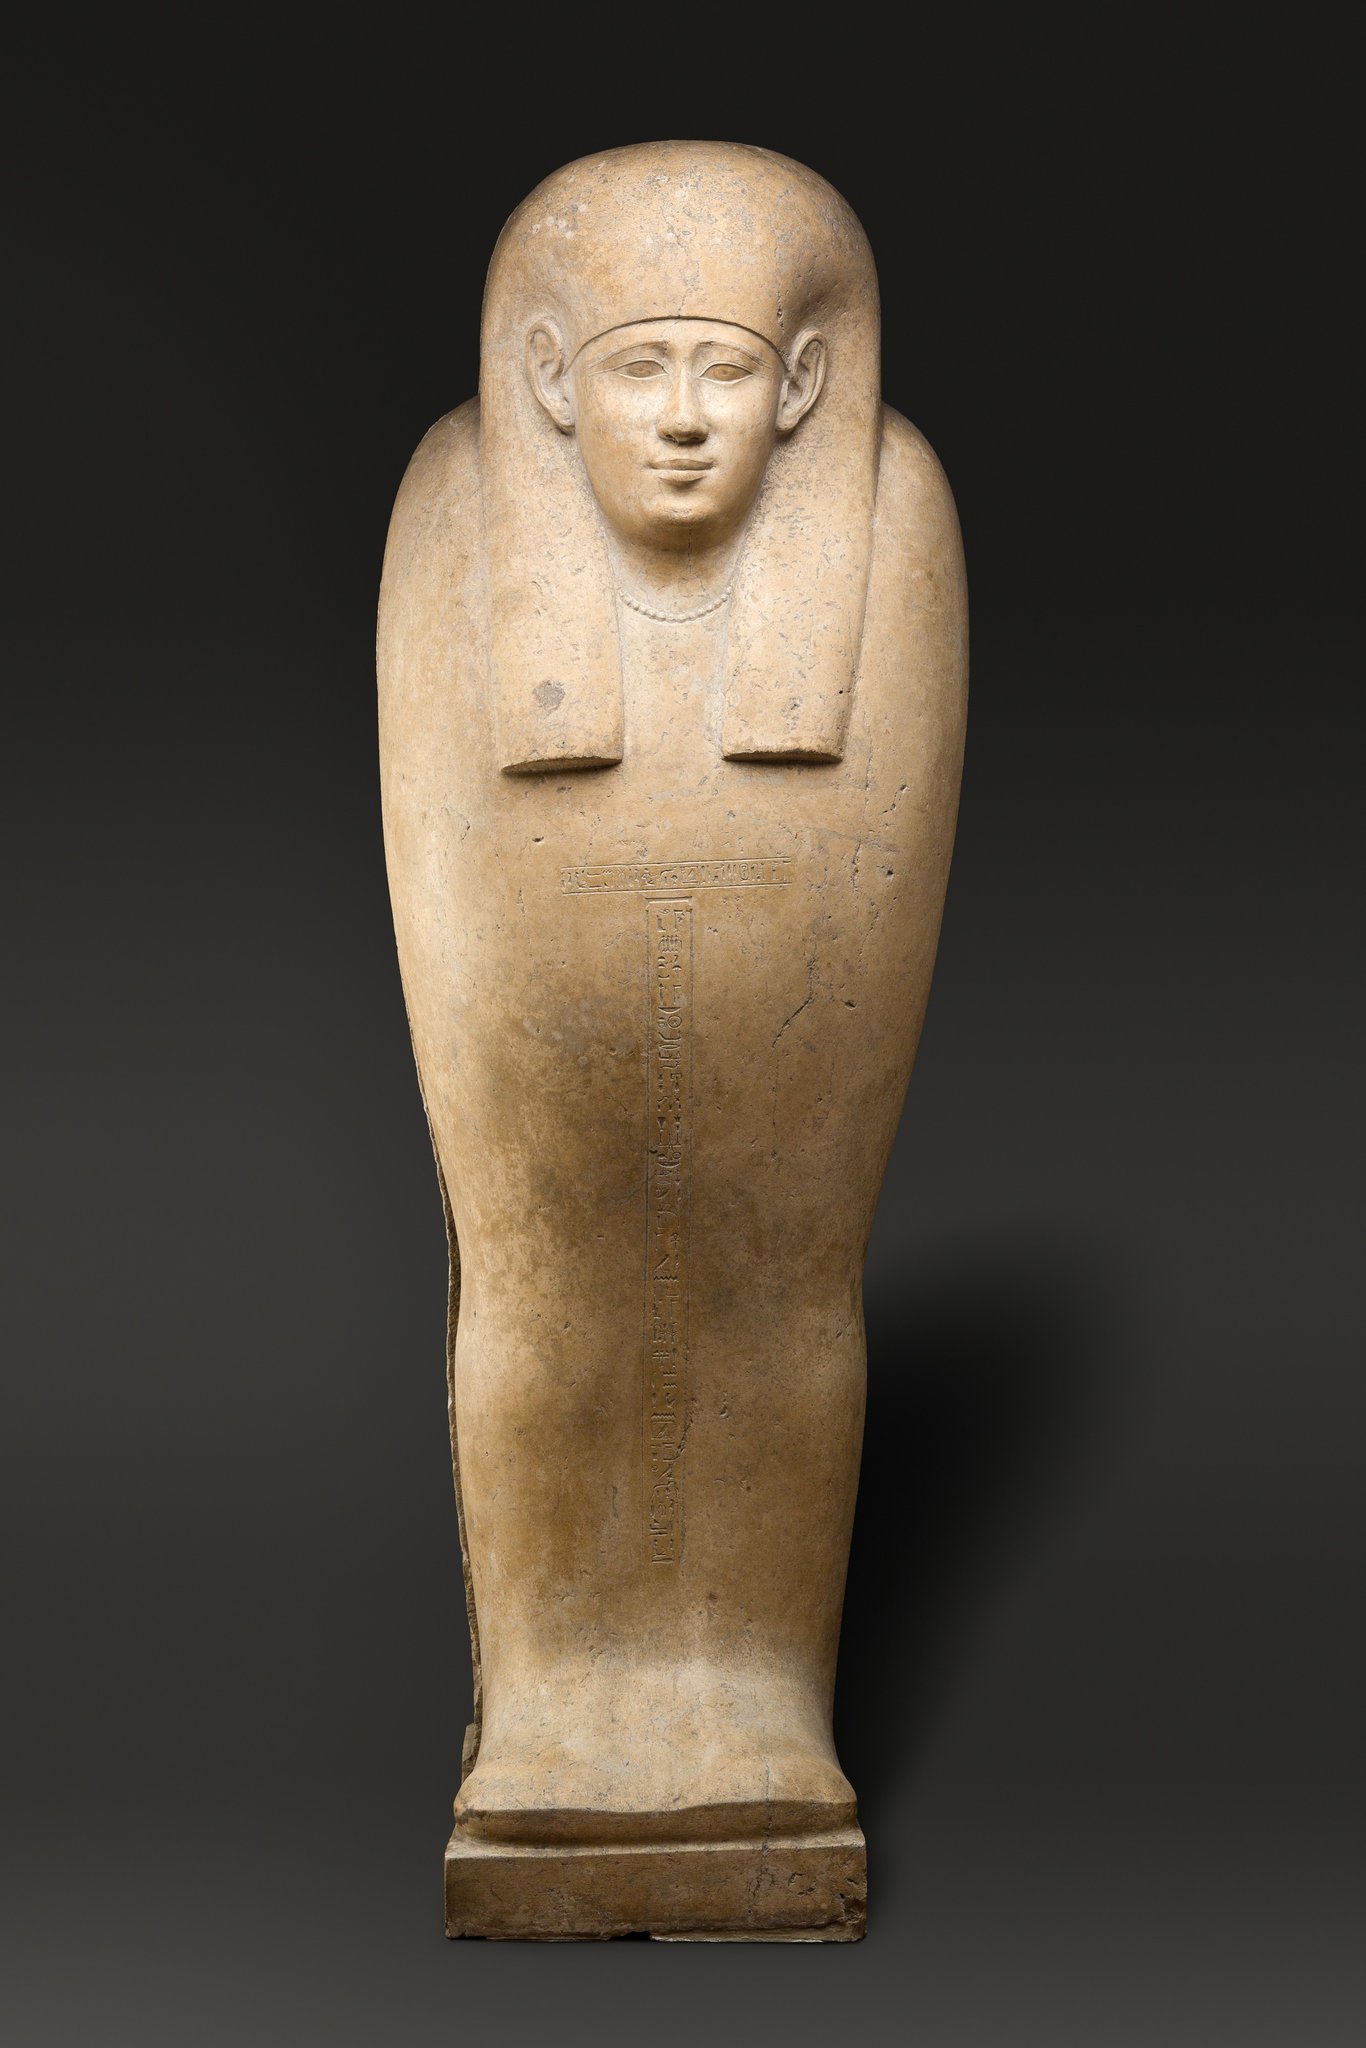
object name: sarcophagus, djedhor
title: Sarcophagus of Djedhor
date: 200-150 BCE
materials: limestone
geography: egypt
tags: hieroglyphs,sarcophagus